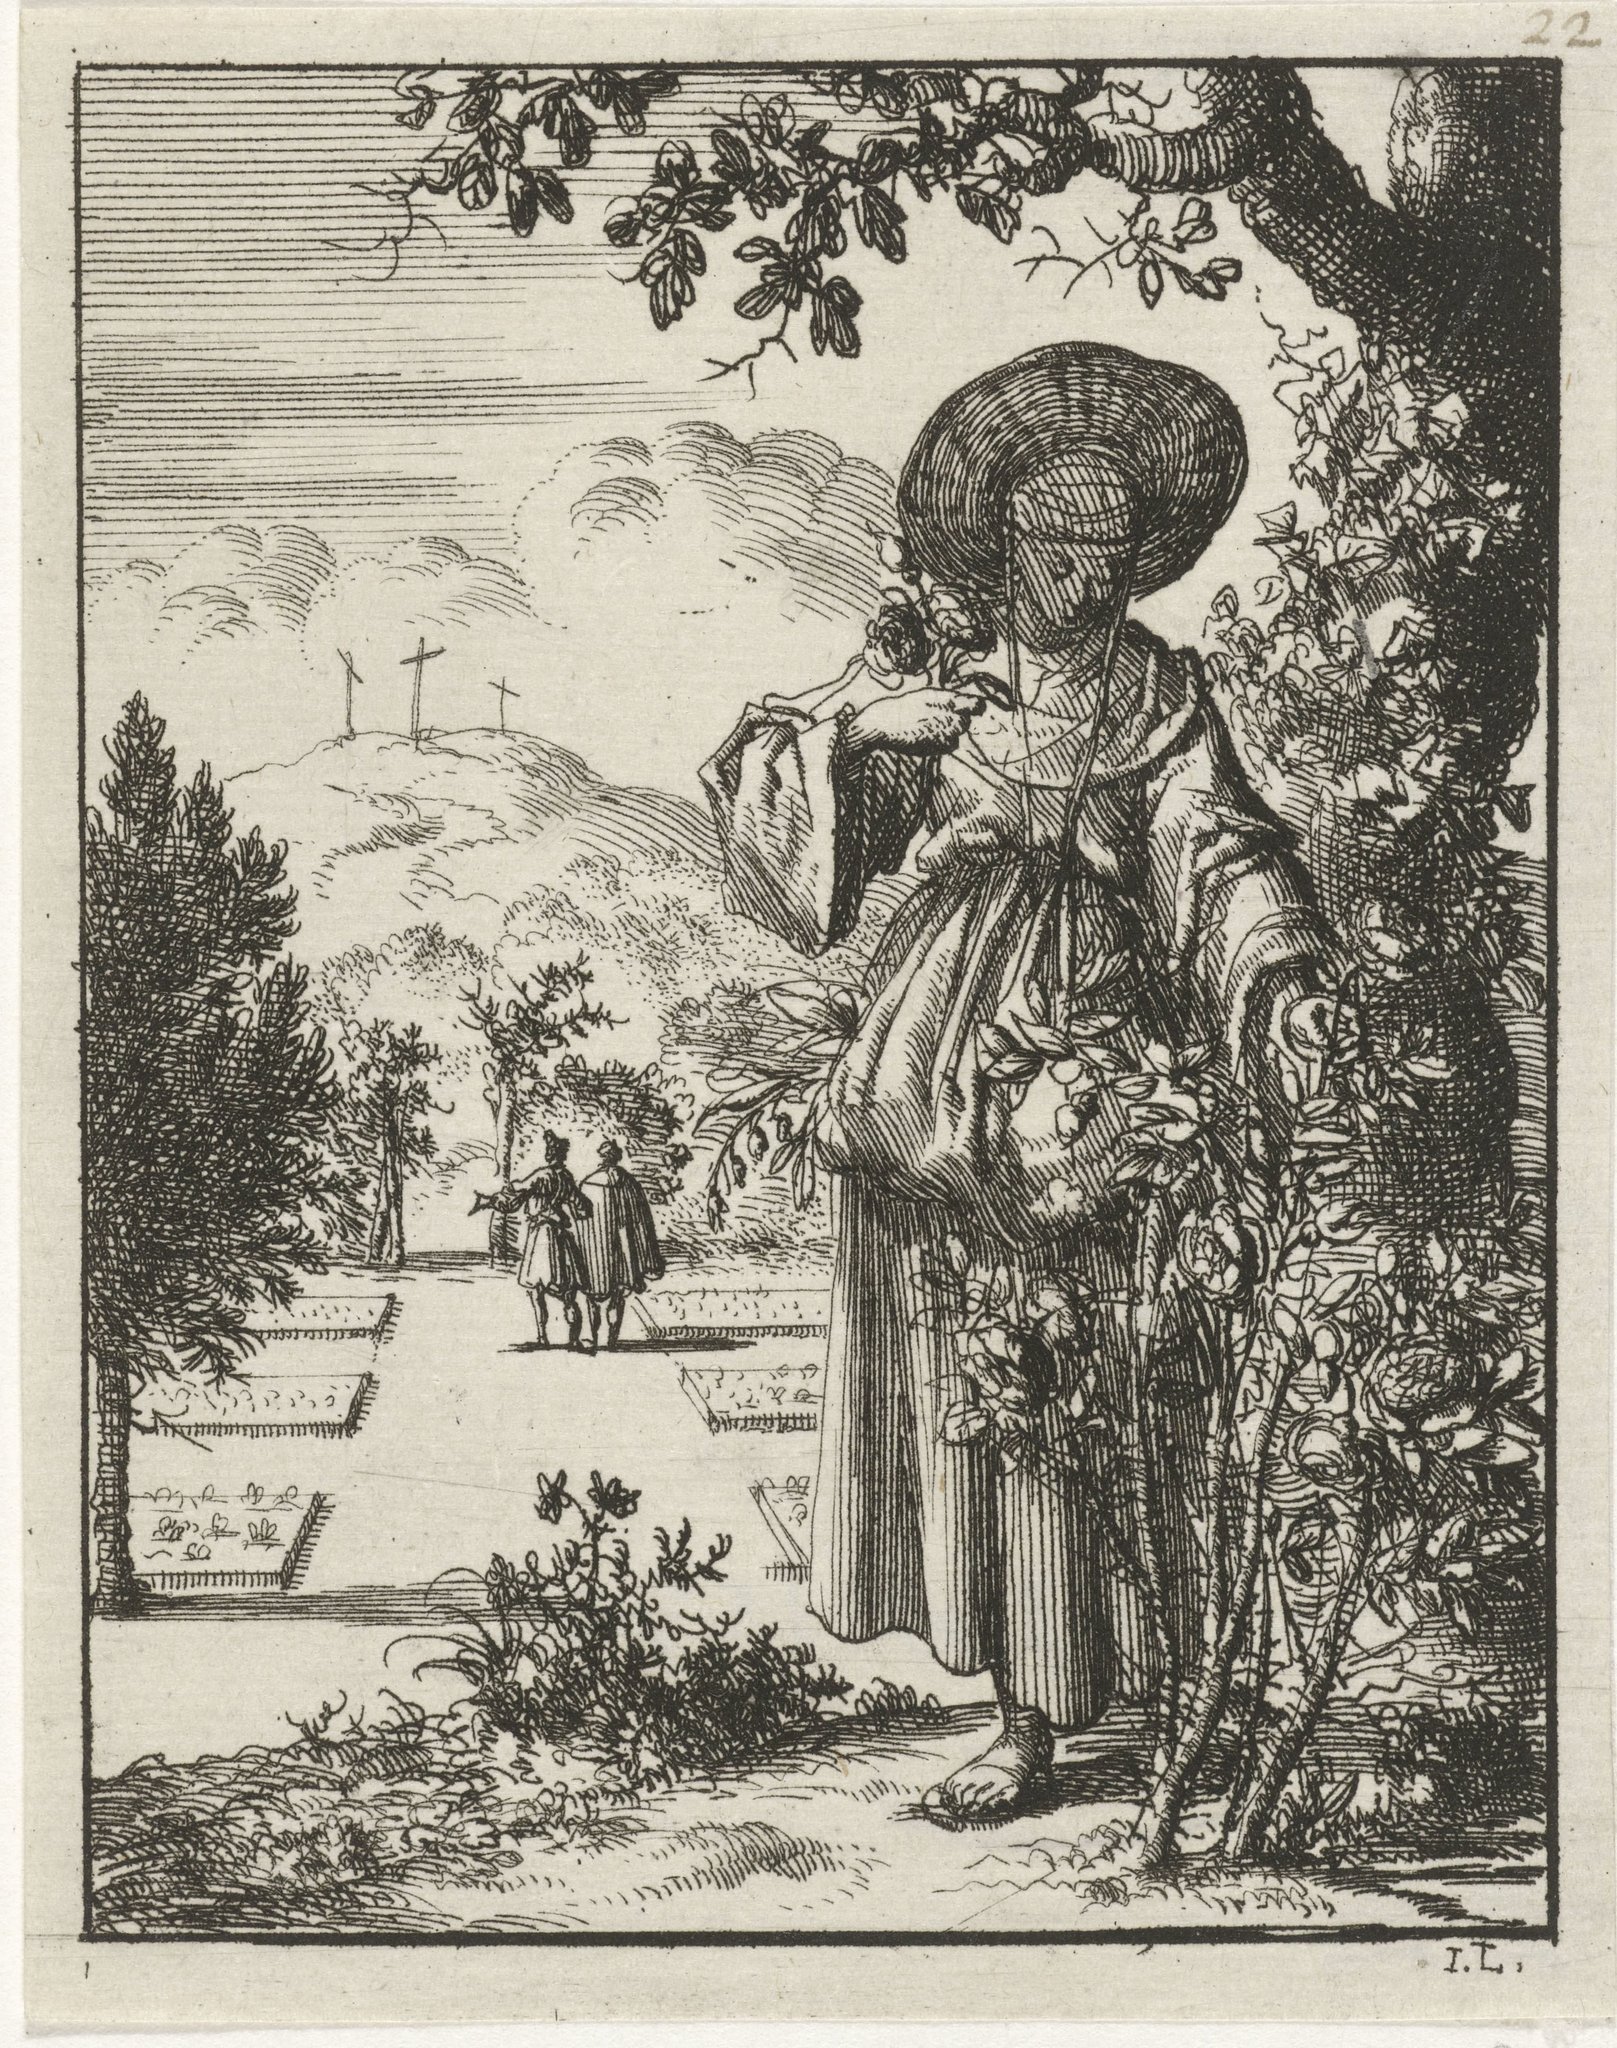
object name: print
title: Vrouw plukt rozen in een tuin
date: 1687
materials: paper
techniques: etching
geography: amsterdam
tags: picking flowers, garden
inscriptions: collector's mark: Lugt 2228, number: ‘22’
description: Illustratie uit: Luyken, Jan. Voncken der liefde Jesu, van het godtbegerende zielenvier. Amsterdam: Pieter Arentsz (II), 1687, p. 88.